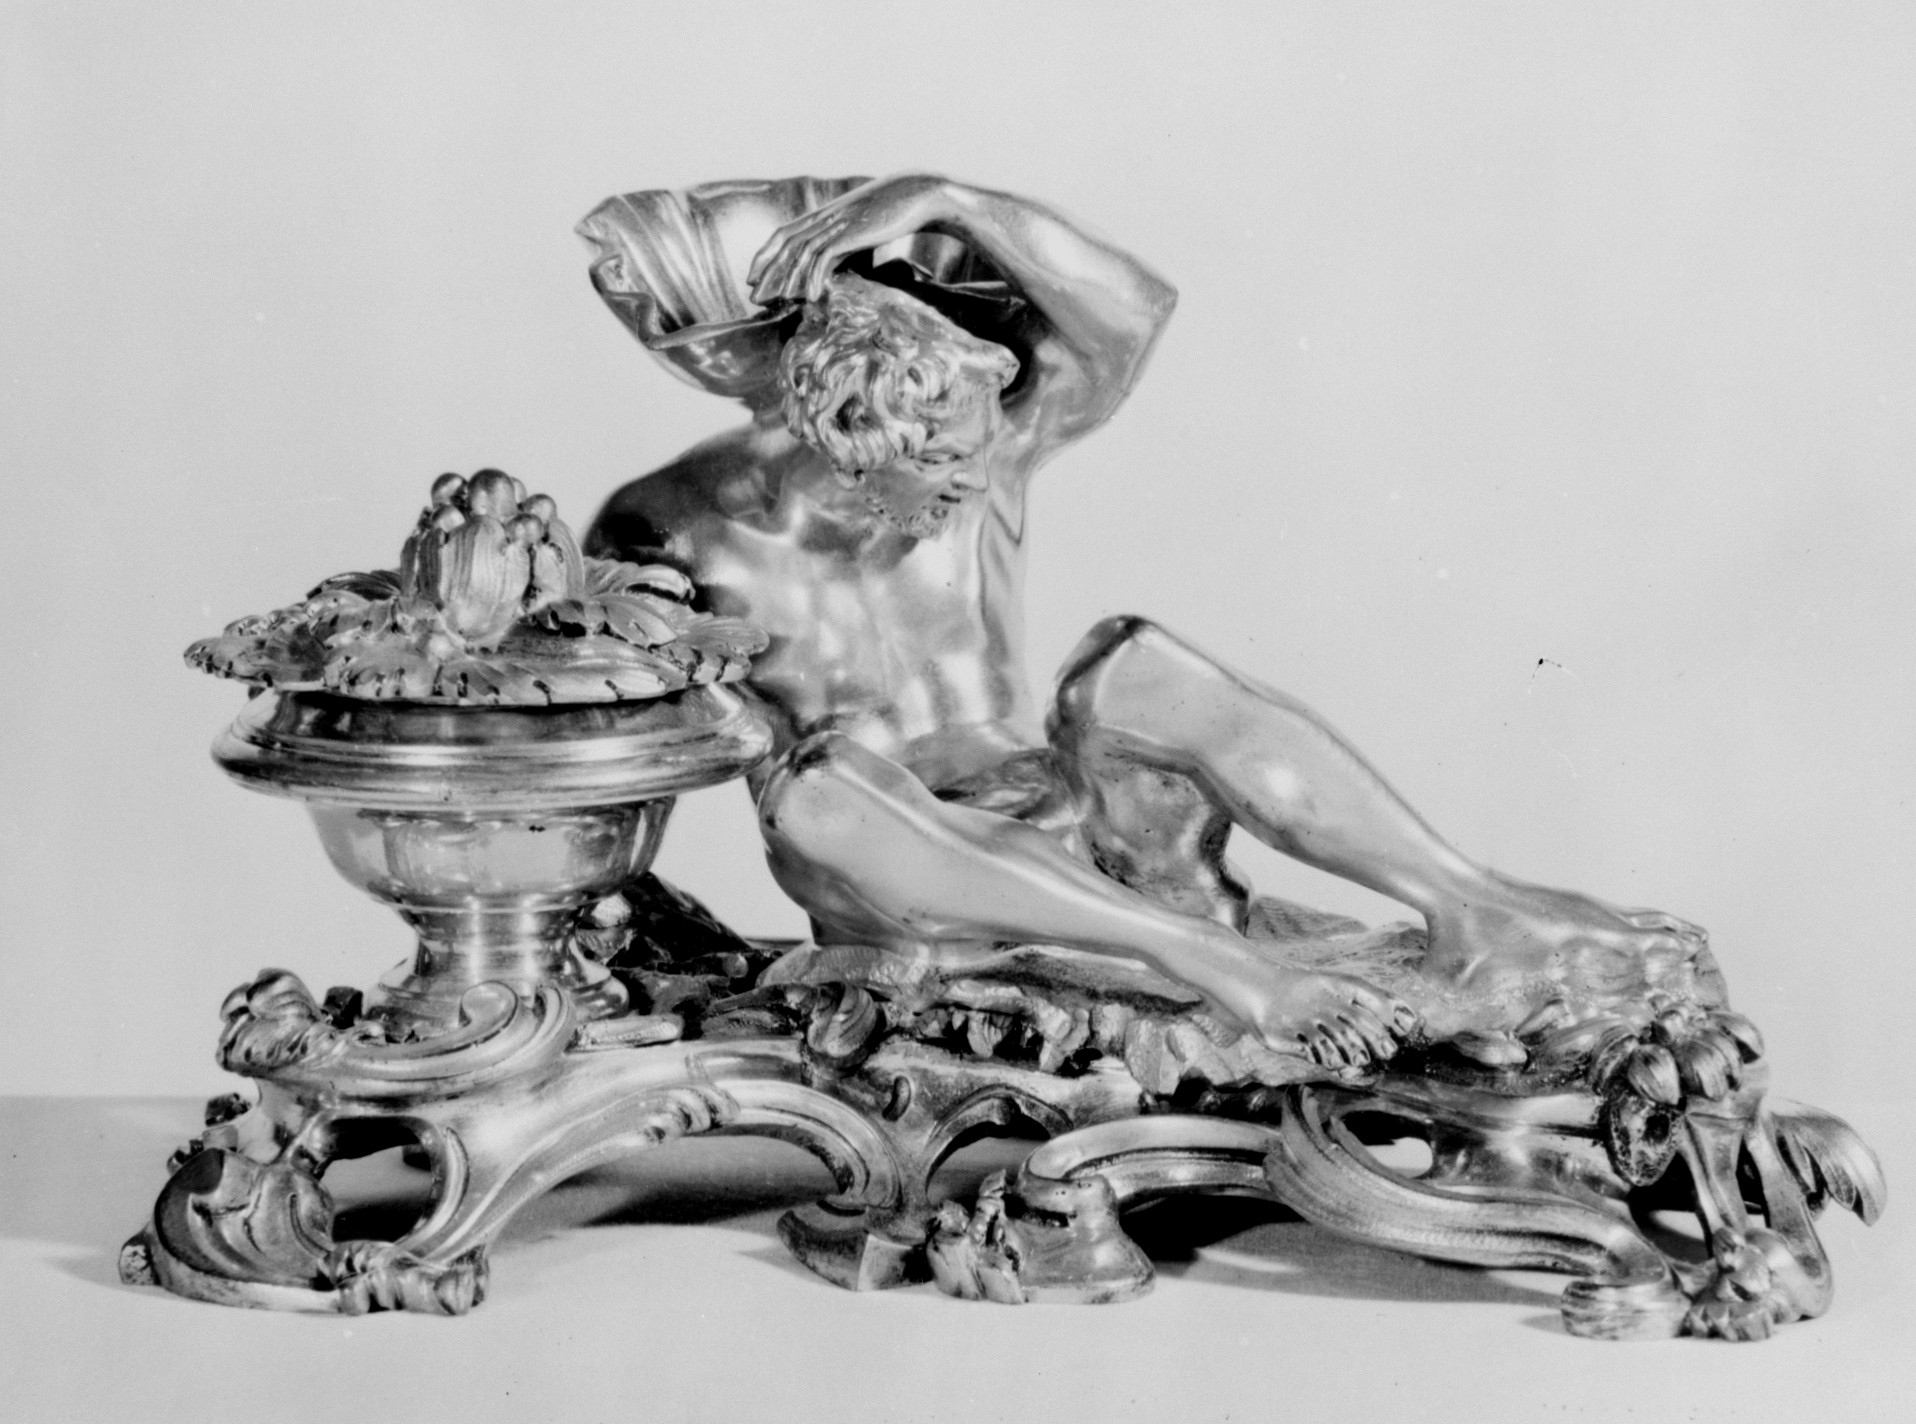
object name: inkwell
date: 1760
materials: gilt bronze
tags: men